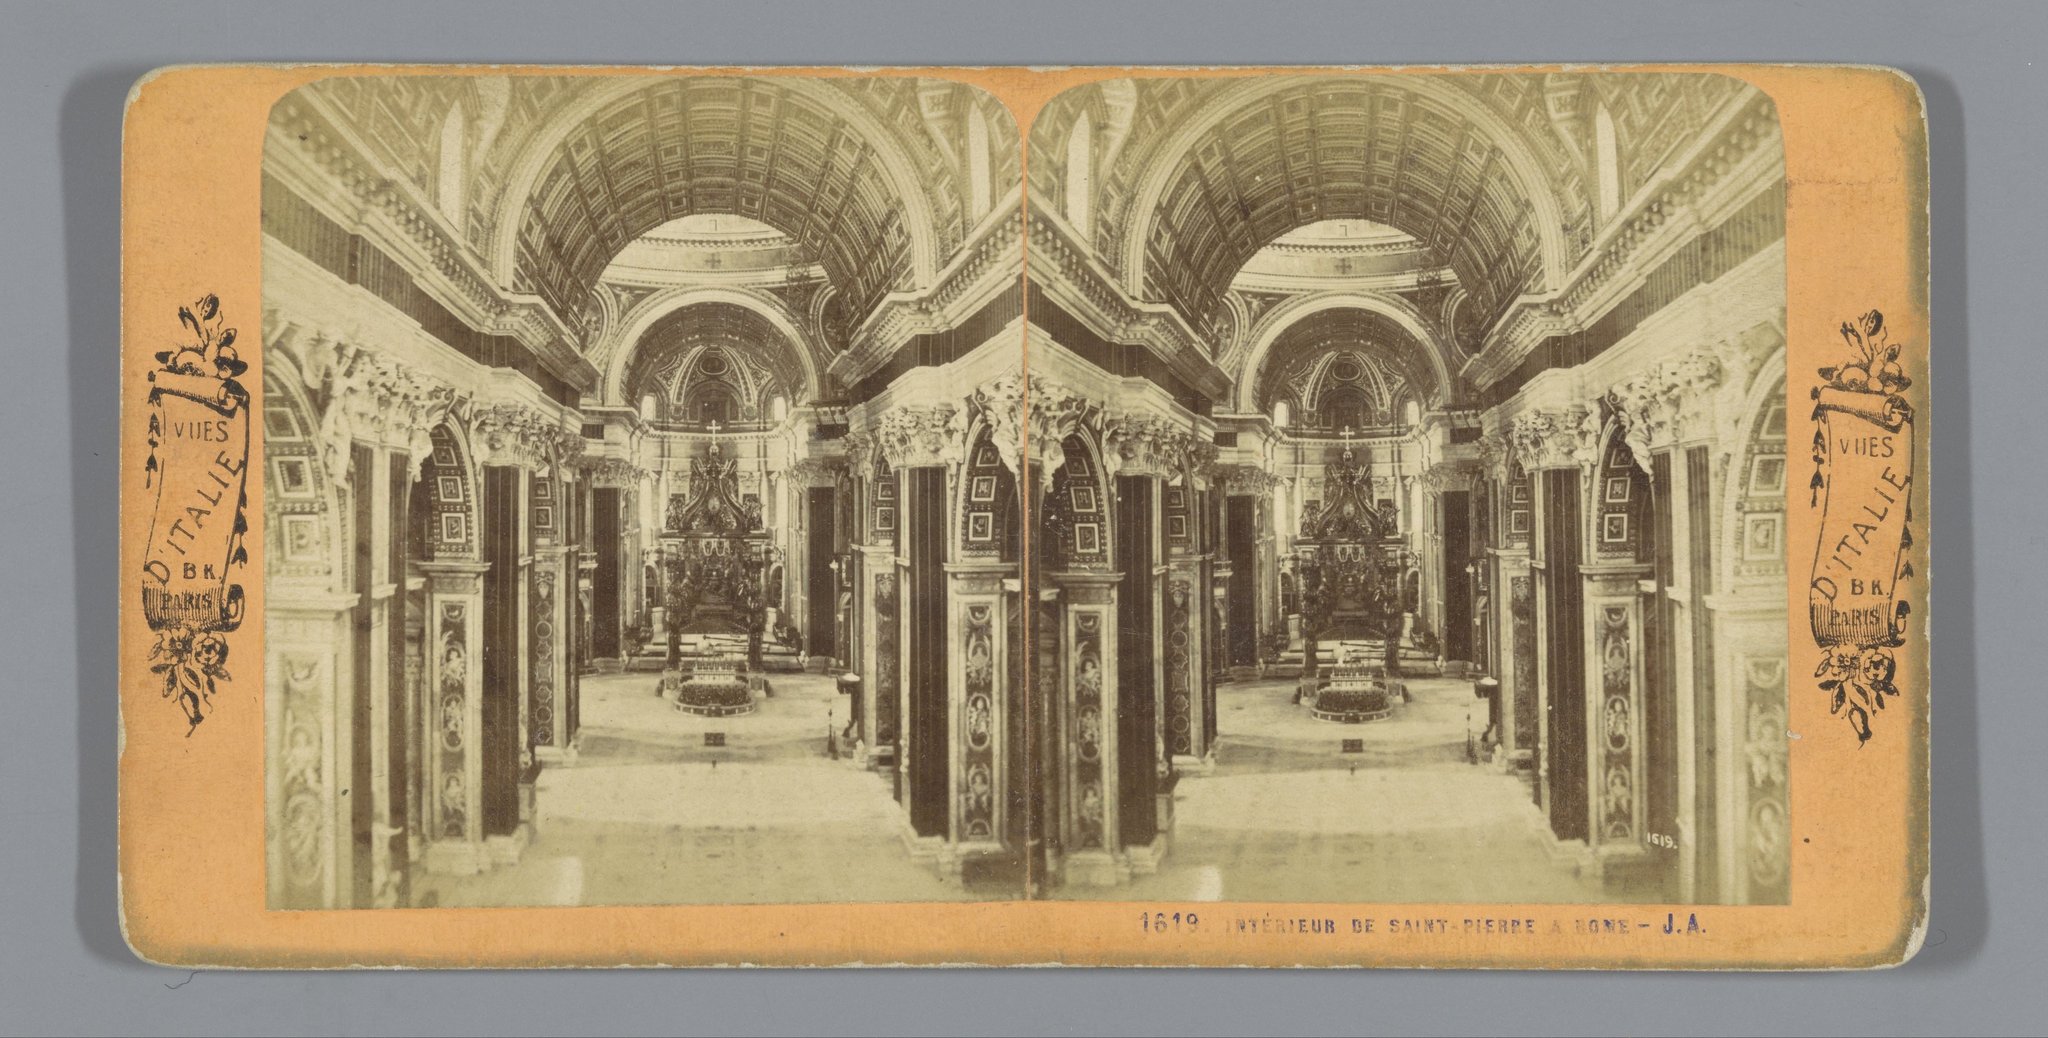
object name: stereograph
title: Vues d'Italie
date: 1872-1876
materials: cardboard, paper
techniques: albumen print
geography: paris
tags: interior of church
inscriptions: number: ‘1619’, inscription: ‘No 1615/ ROME INTERIEUR SINT PIETER’